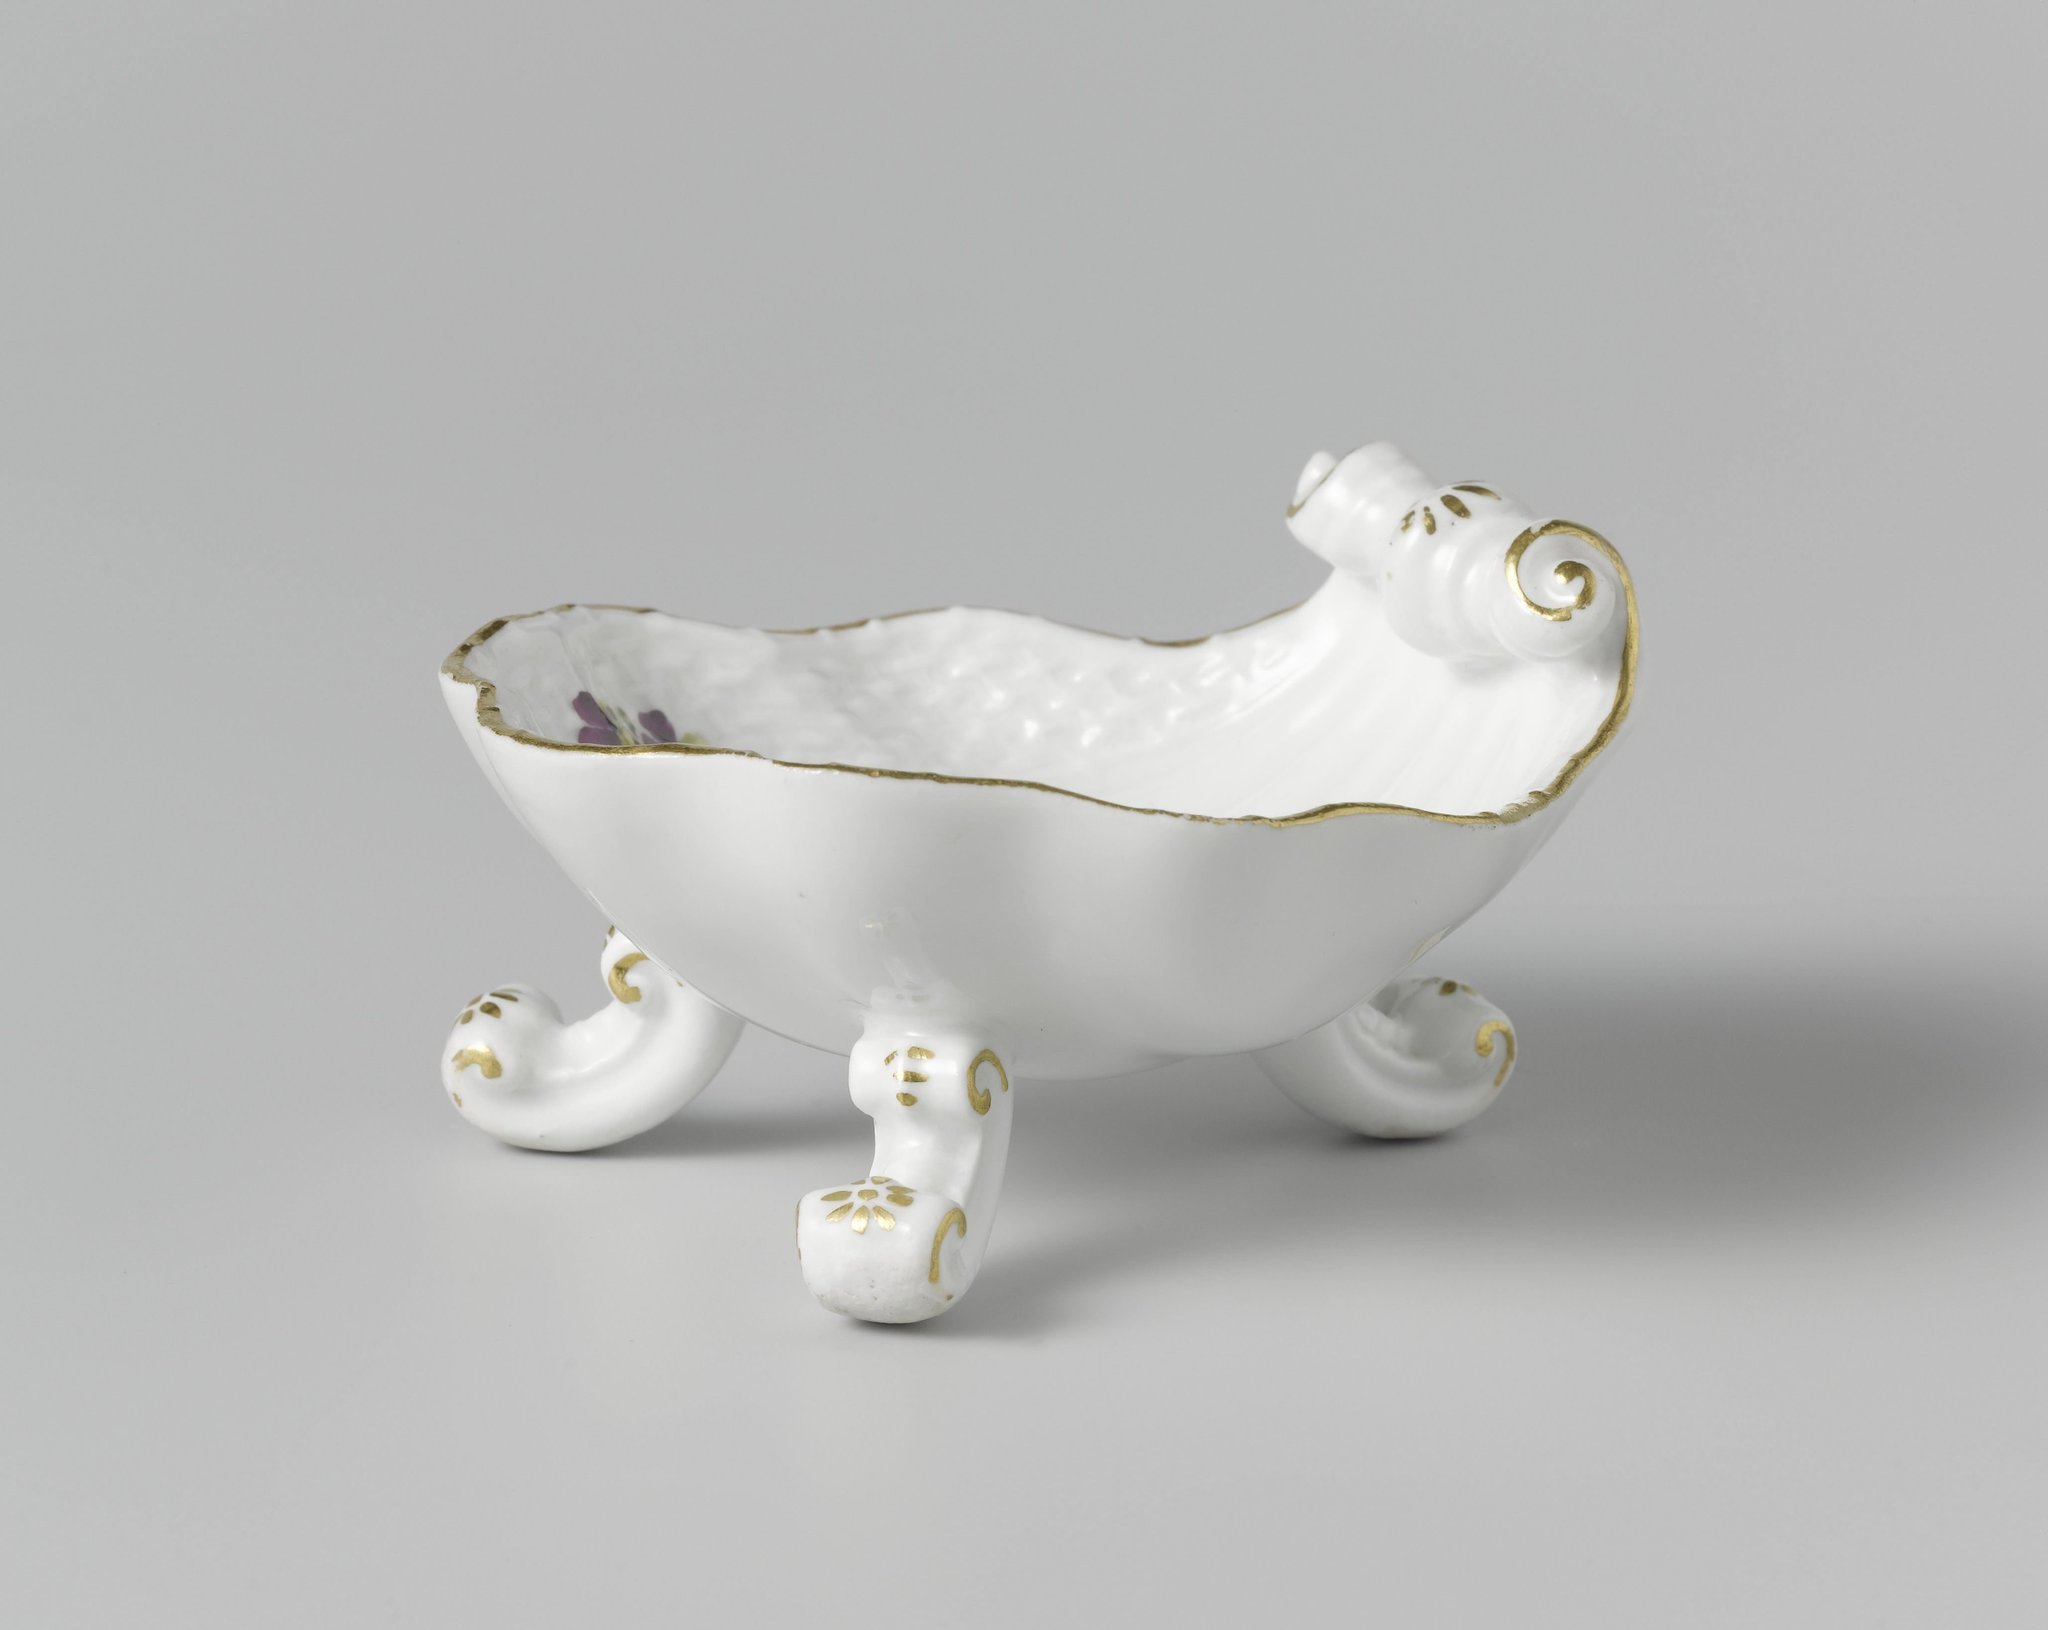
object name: salt condiment vessel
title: Zoutvat, veelkleurig beschilderd met Deutsche Blumen, insekten en vruchten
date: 1750-1760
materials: porcelain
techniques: painted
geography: meissen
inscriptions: factory mark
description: Zoutvat van beschilderd porselein. Het zoutvat heeft de vorm van een schelp met een geschulpte rand en staat op drie voluutvormige poten. Het zoutvat is beschilderd met Deutsche Blumen, insekten en vruchten. De rand is versierd met het Neuozier-patroon in reliëf. Het zoutvat is gemerkt en hoort bij een servies (BK-17474-1 t/m BK-17474-253).